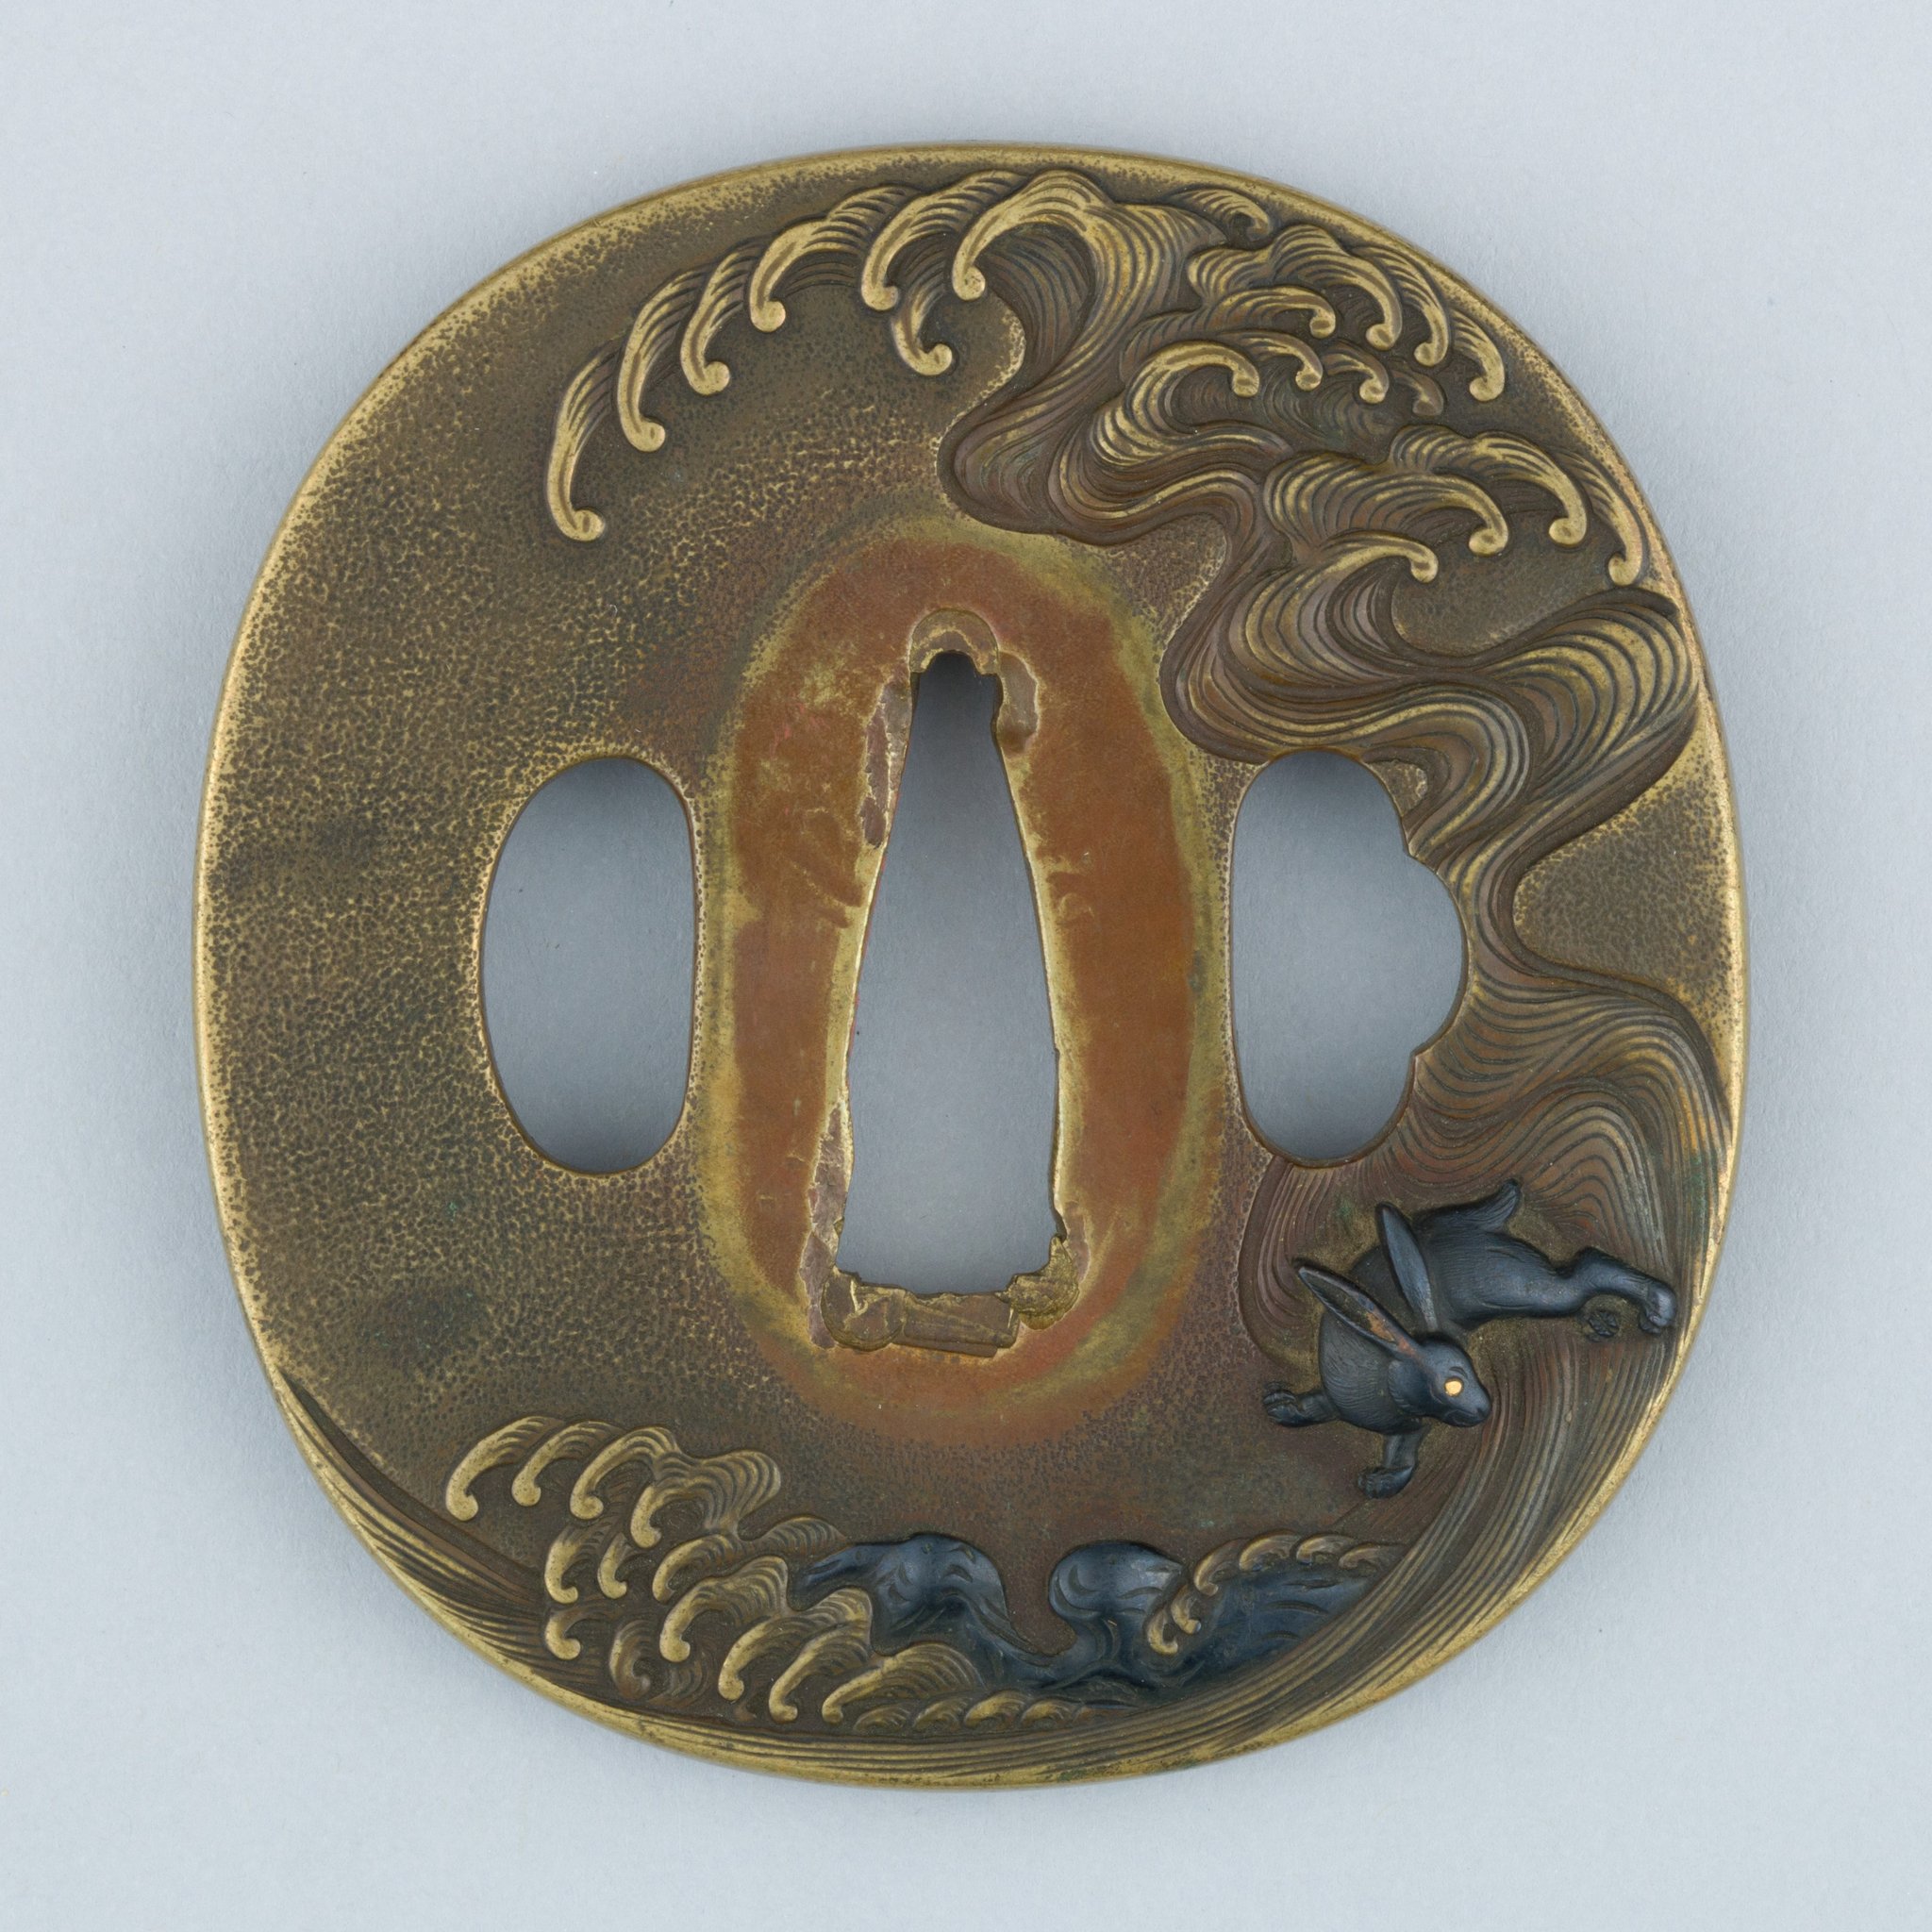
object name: sword guard tsuba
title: Sword Guard (Tsuba)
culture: japanese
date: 1615-1868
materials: copper, copper alloy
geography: japan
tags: rabbits,waves